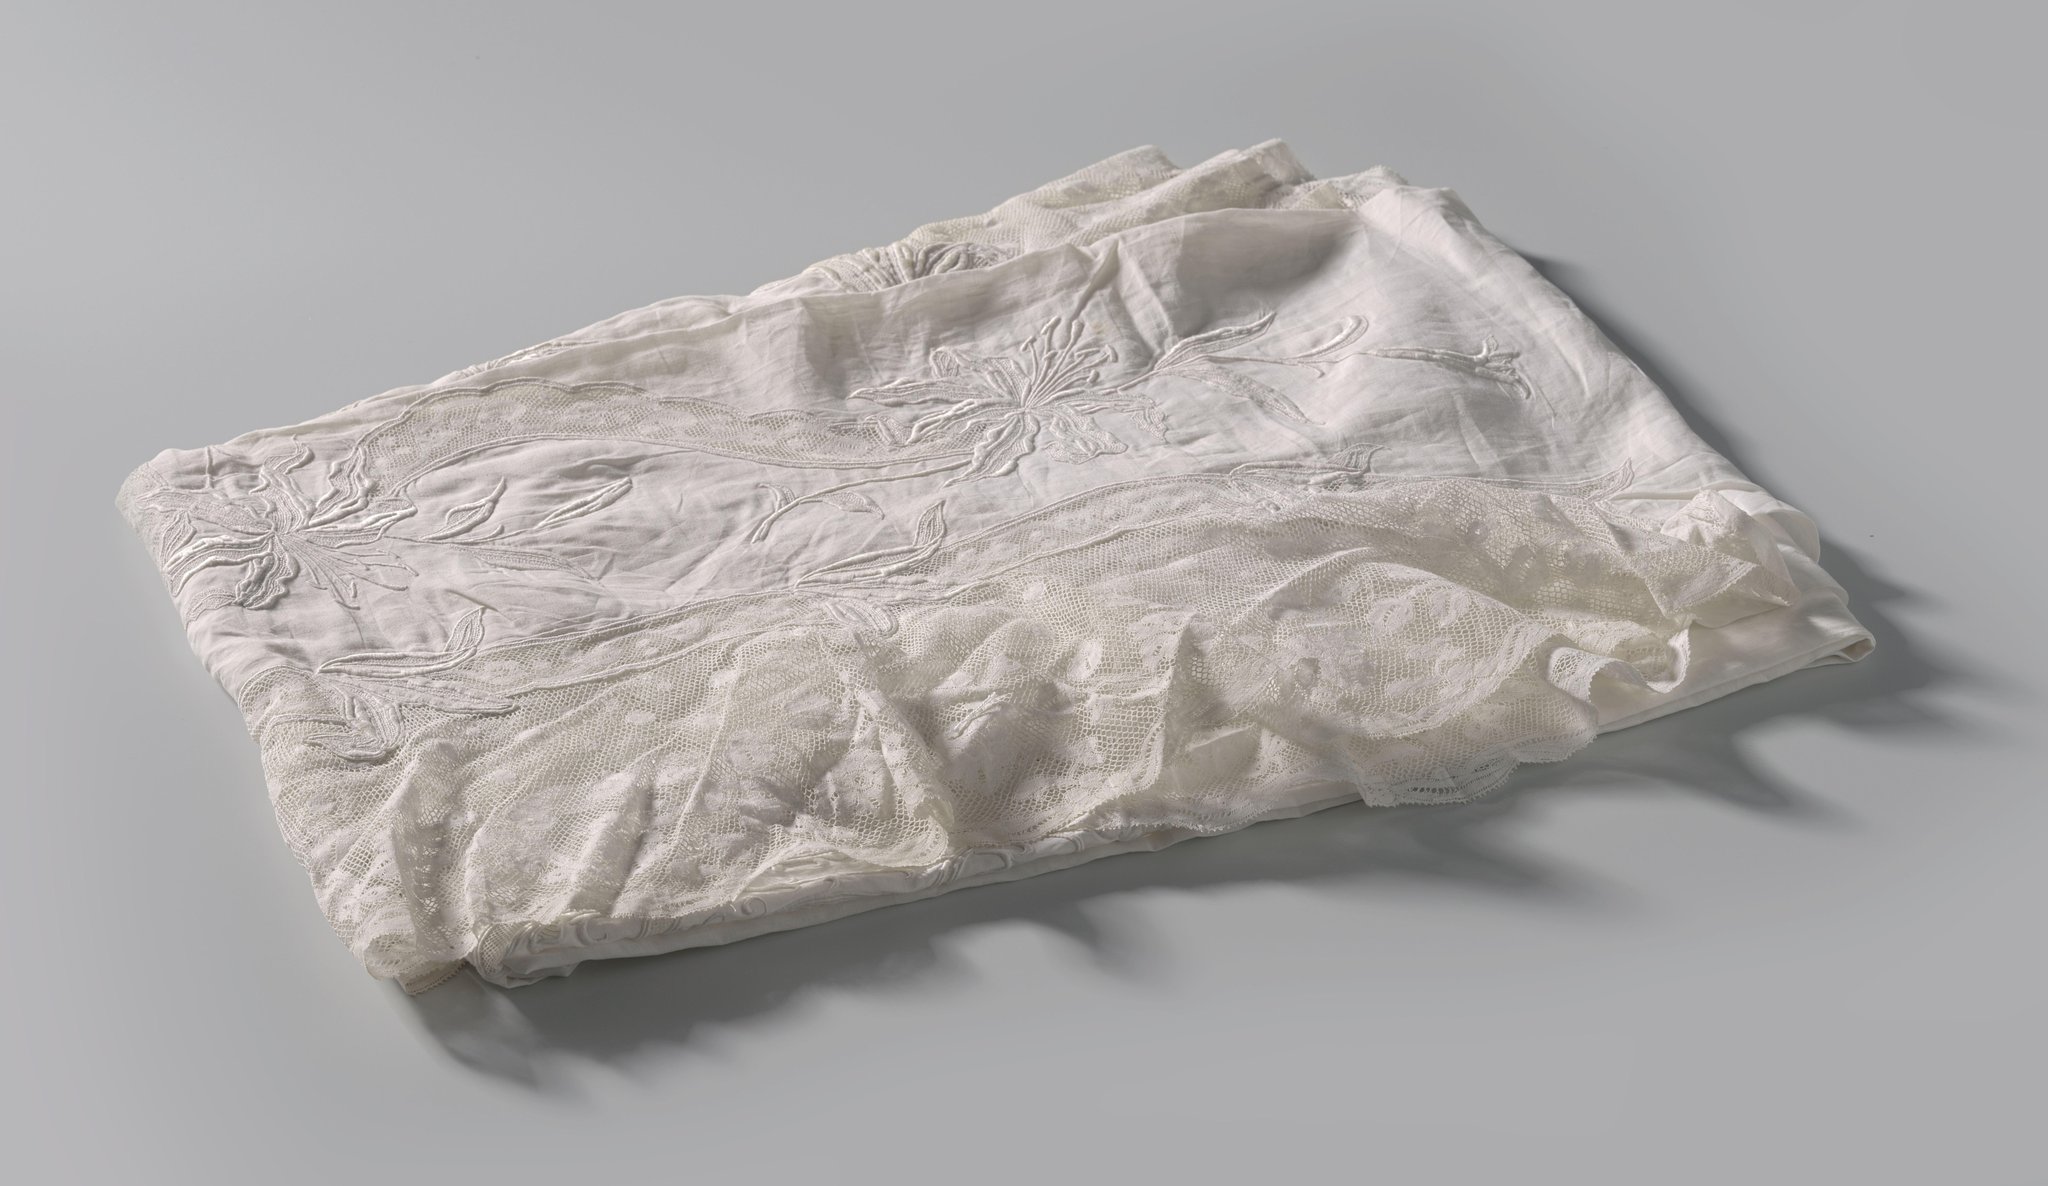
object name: beddenlaken, laken object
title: Laken met in wit geborduurd de naam Lucille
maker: Anonymous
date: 1890-1910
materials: yarns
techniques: lace, embroidered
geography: netherlands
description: Laken met twee bijbehorende slopen (b,c), in wit geborduurd met de naam Lucille en met een rand van kloskant, type Valenciennes.